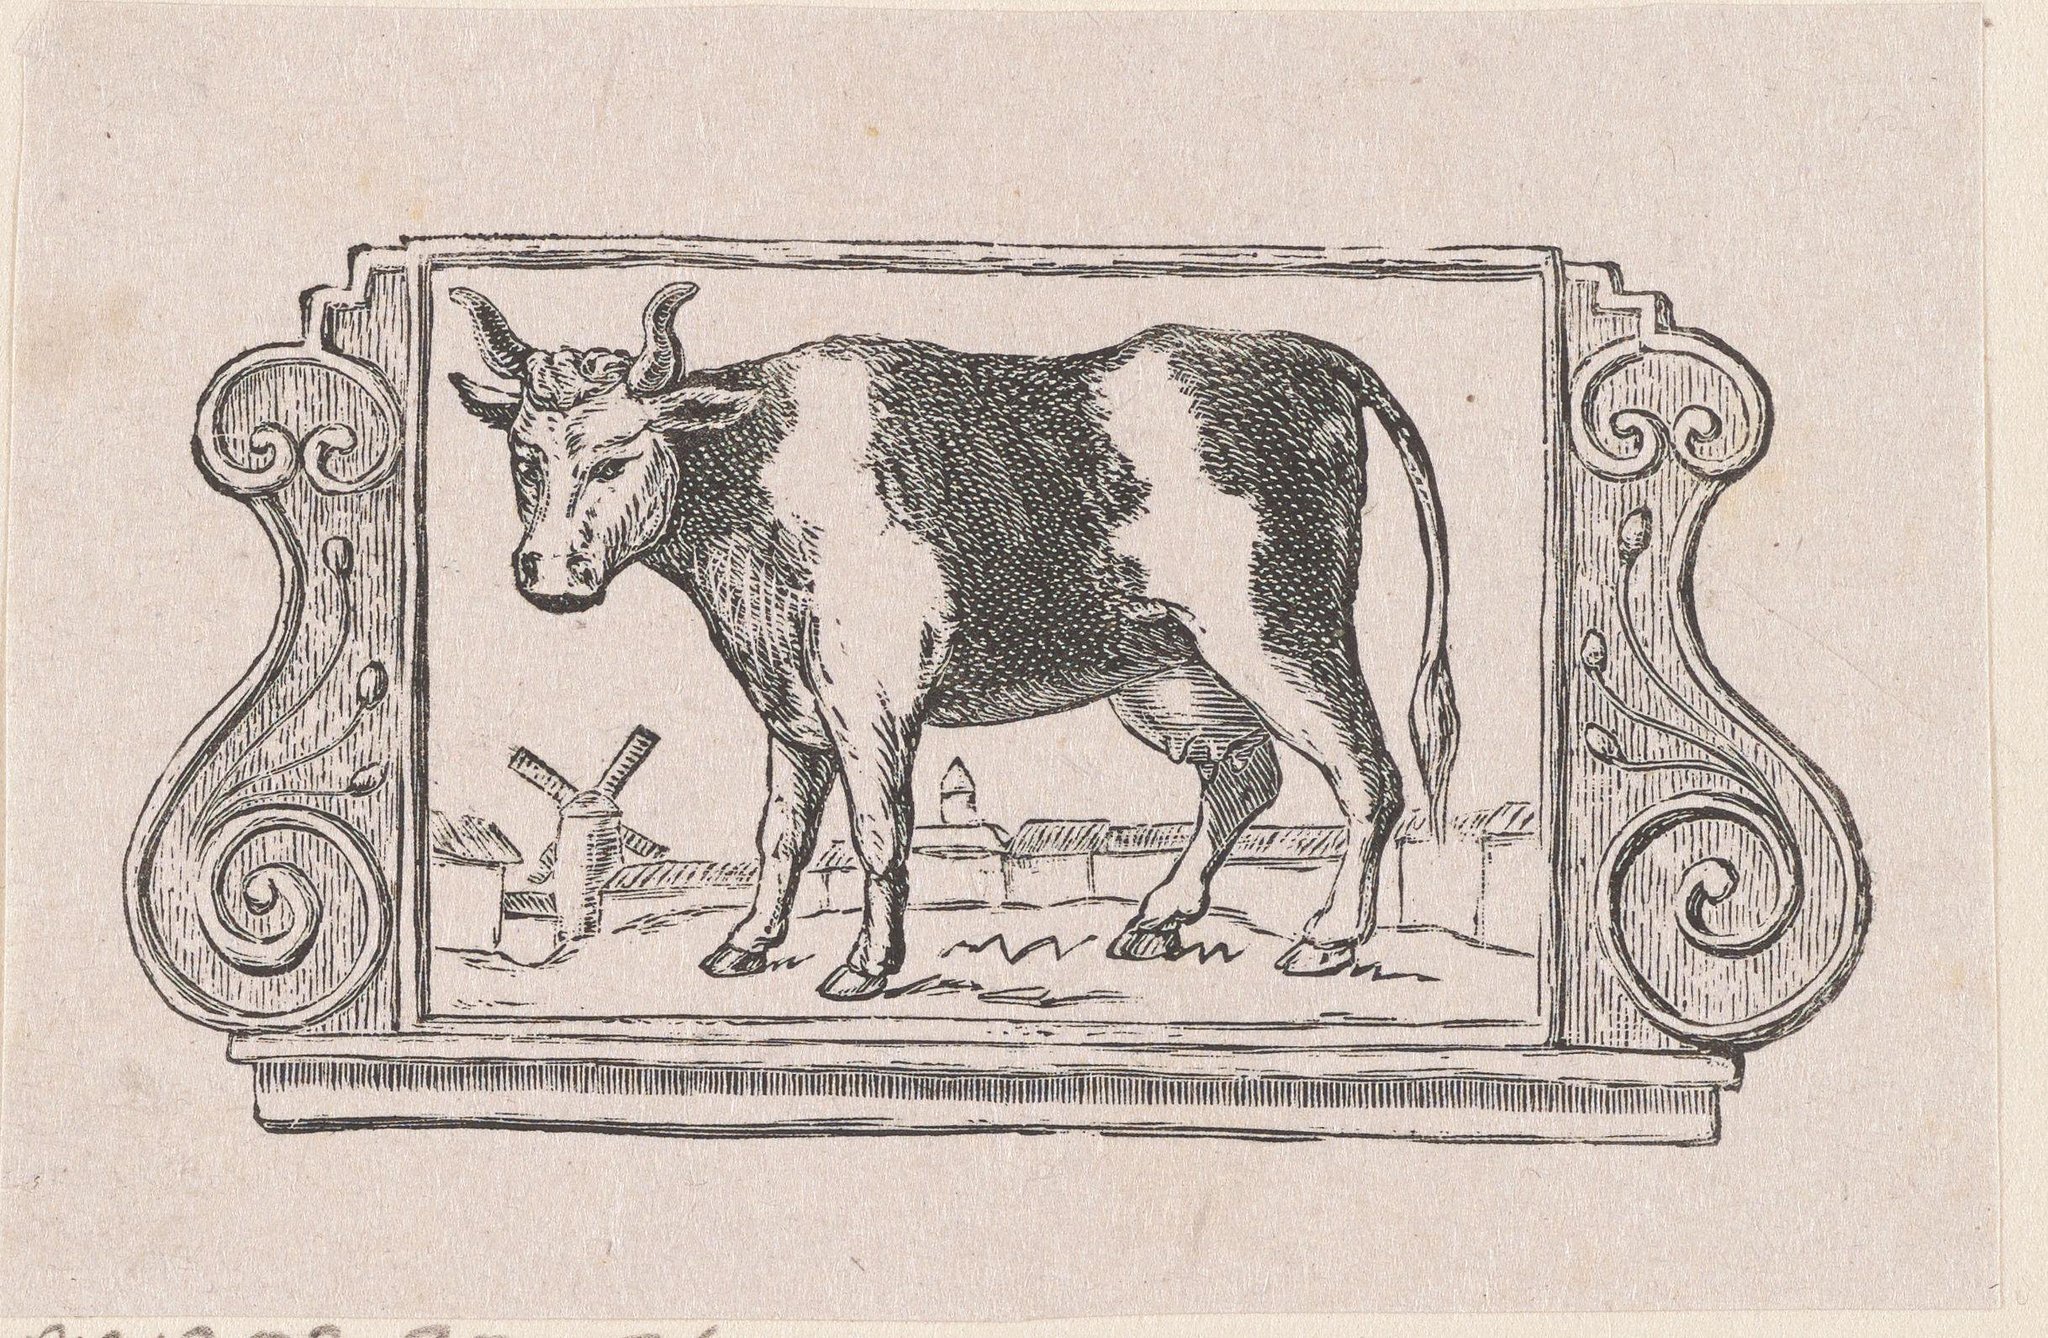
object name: print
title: Vignet met een koe in een landschap met een molen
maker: isaac weissenbruch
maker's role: print maker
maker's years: 1826-1912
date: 1836-1912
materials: paper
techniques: engraving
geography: netherlands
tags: cow, windmill in landscape, vignette